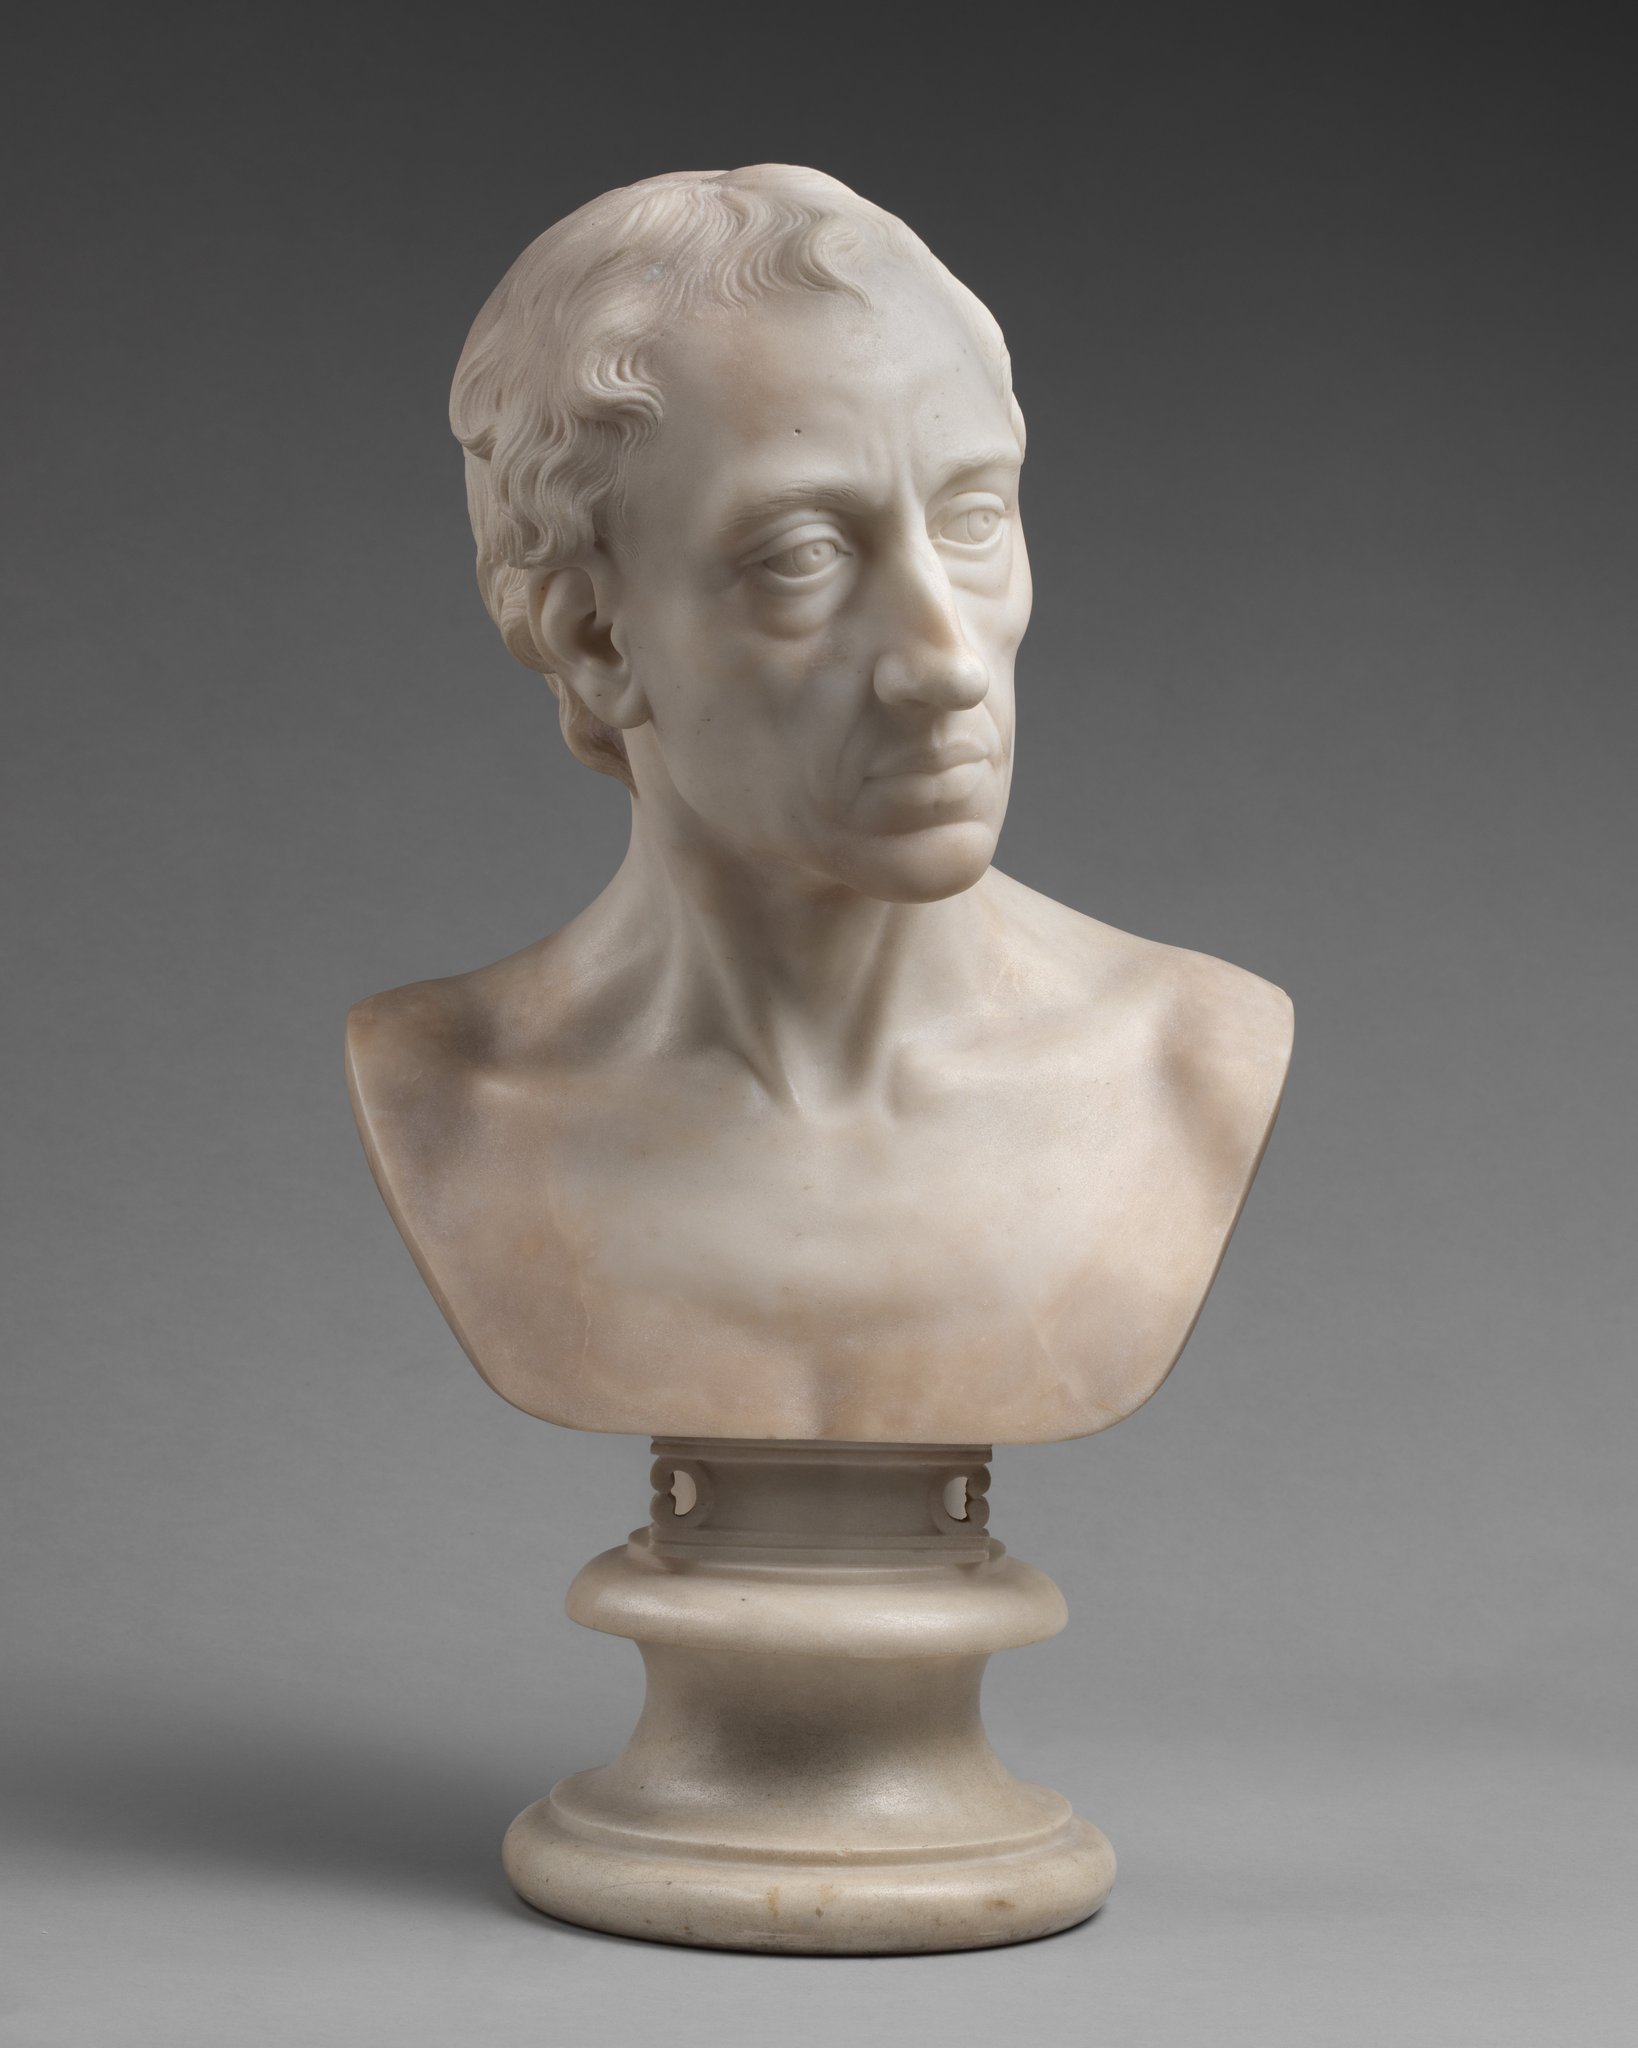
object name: bust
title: Alexander Pope (1688–1744)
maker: joseph nollekens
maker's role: artist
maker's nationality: british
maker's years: 1737-1823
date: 1767-1800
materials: marble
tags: men,portraits